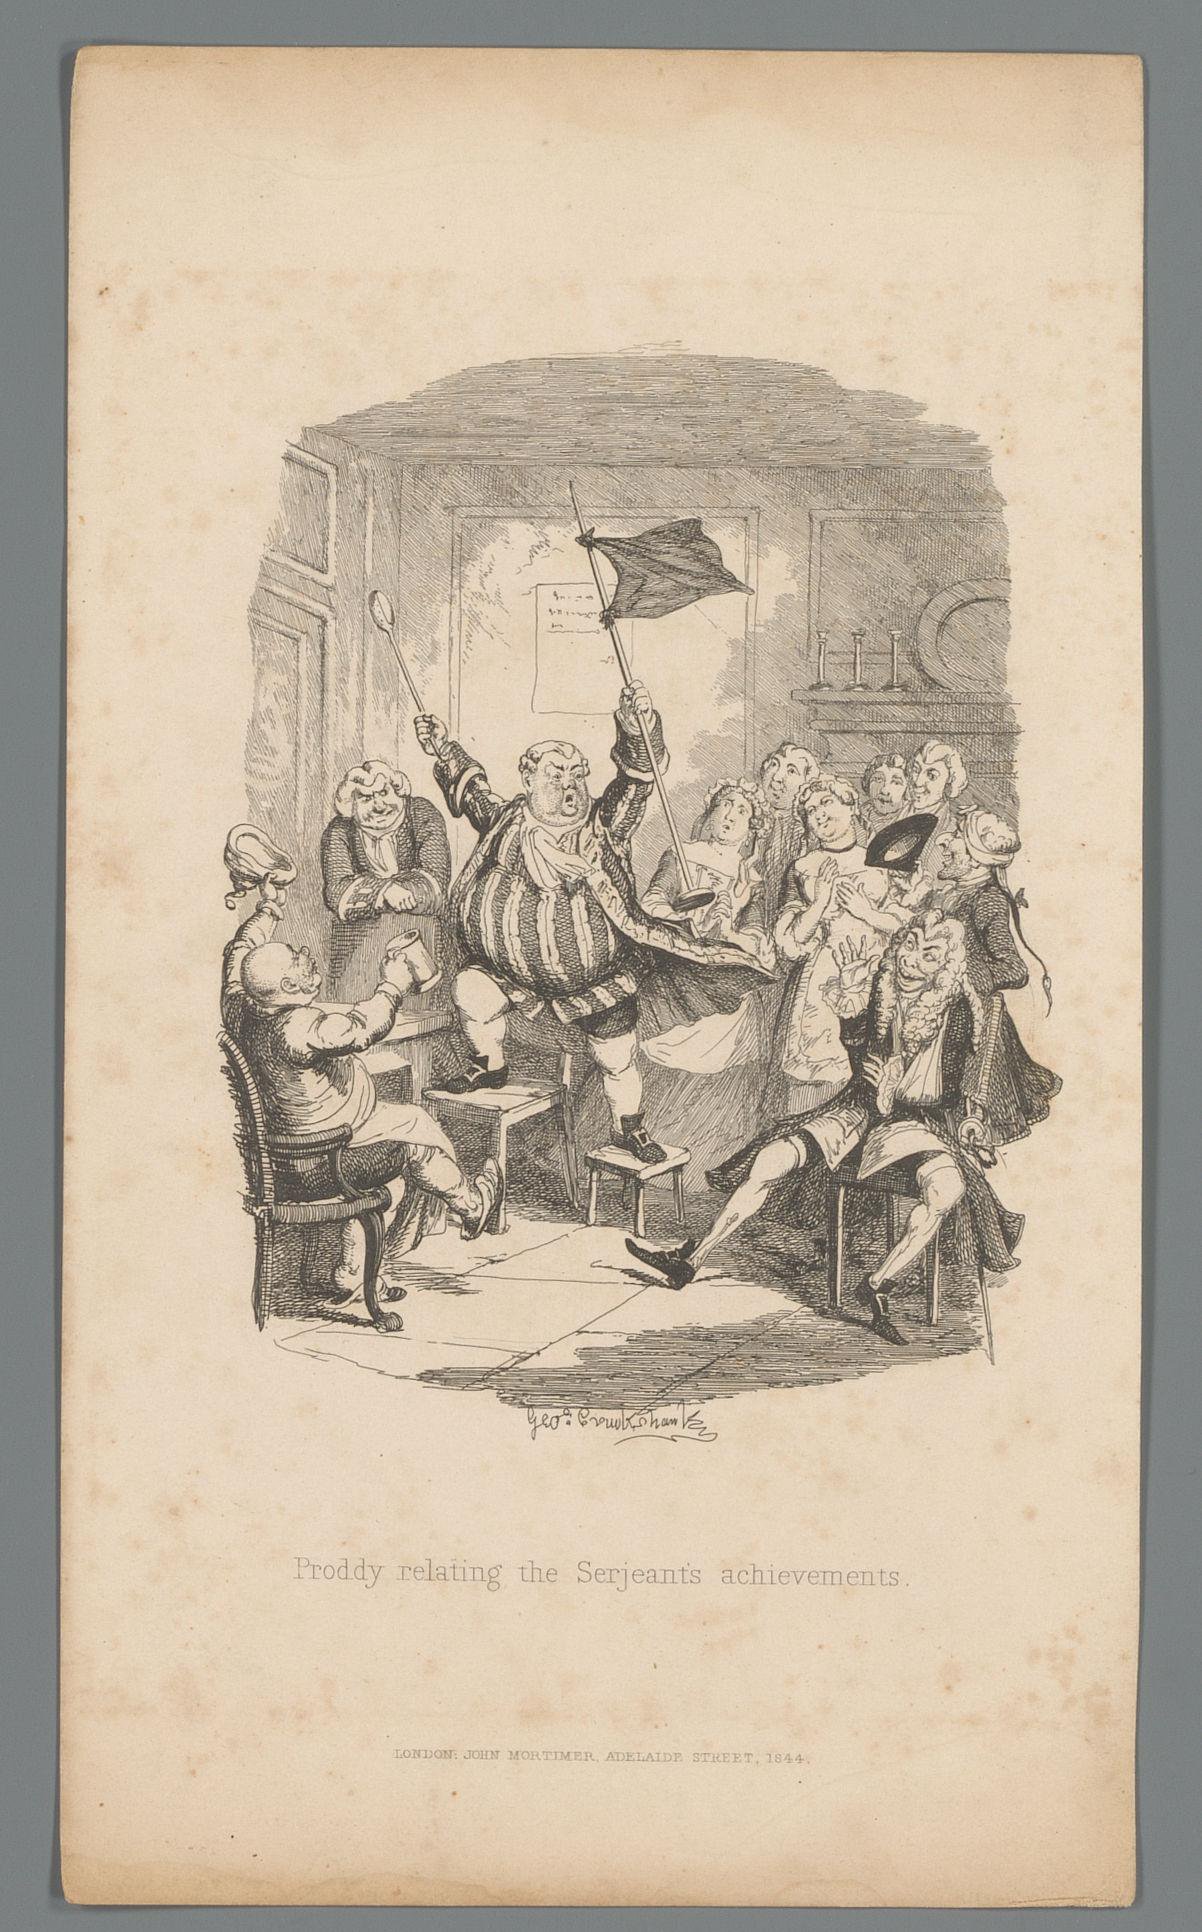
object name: print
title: Proddy over de sergeant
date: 1844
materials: paper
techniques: etching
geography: london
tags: political caricatures and satires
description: Proddy speelt de avonturen van sergeant Scales na, tot groot vermaak van zijn toehoorders. Illustratie voor een uitgave van "St James's, or the Court of Queen Anne" van Ainsworth, 1844.